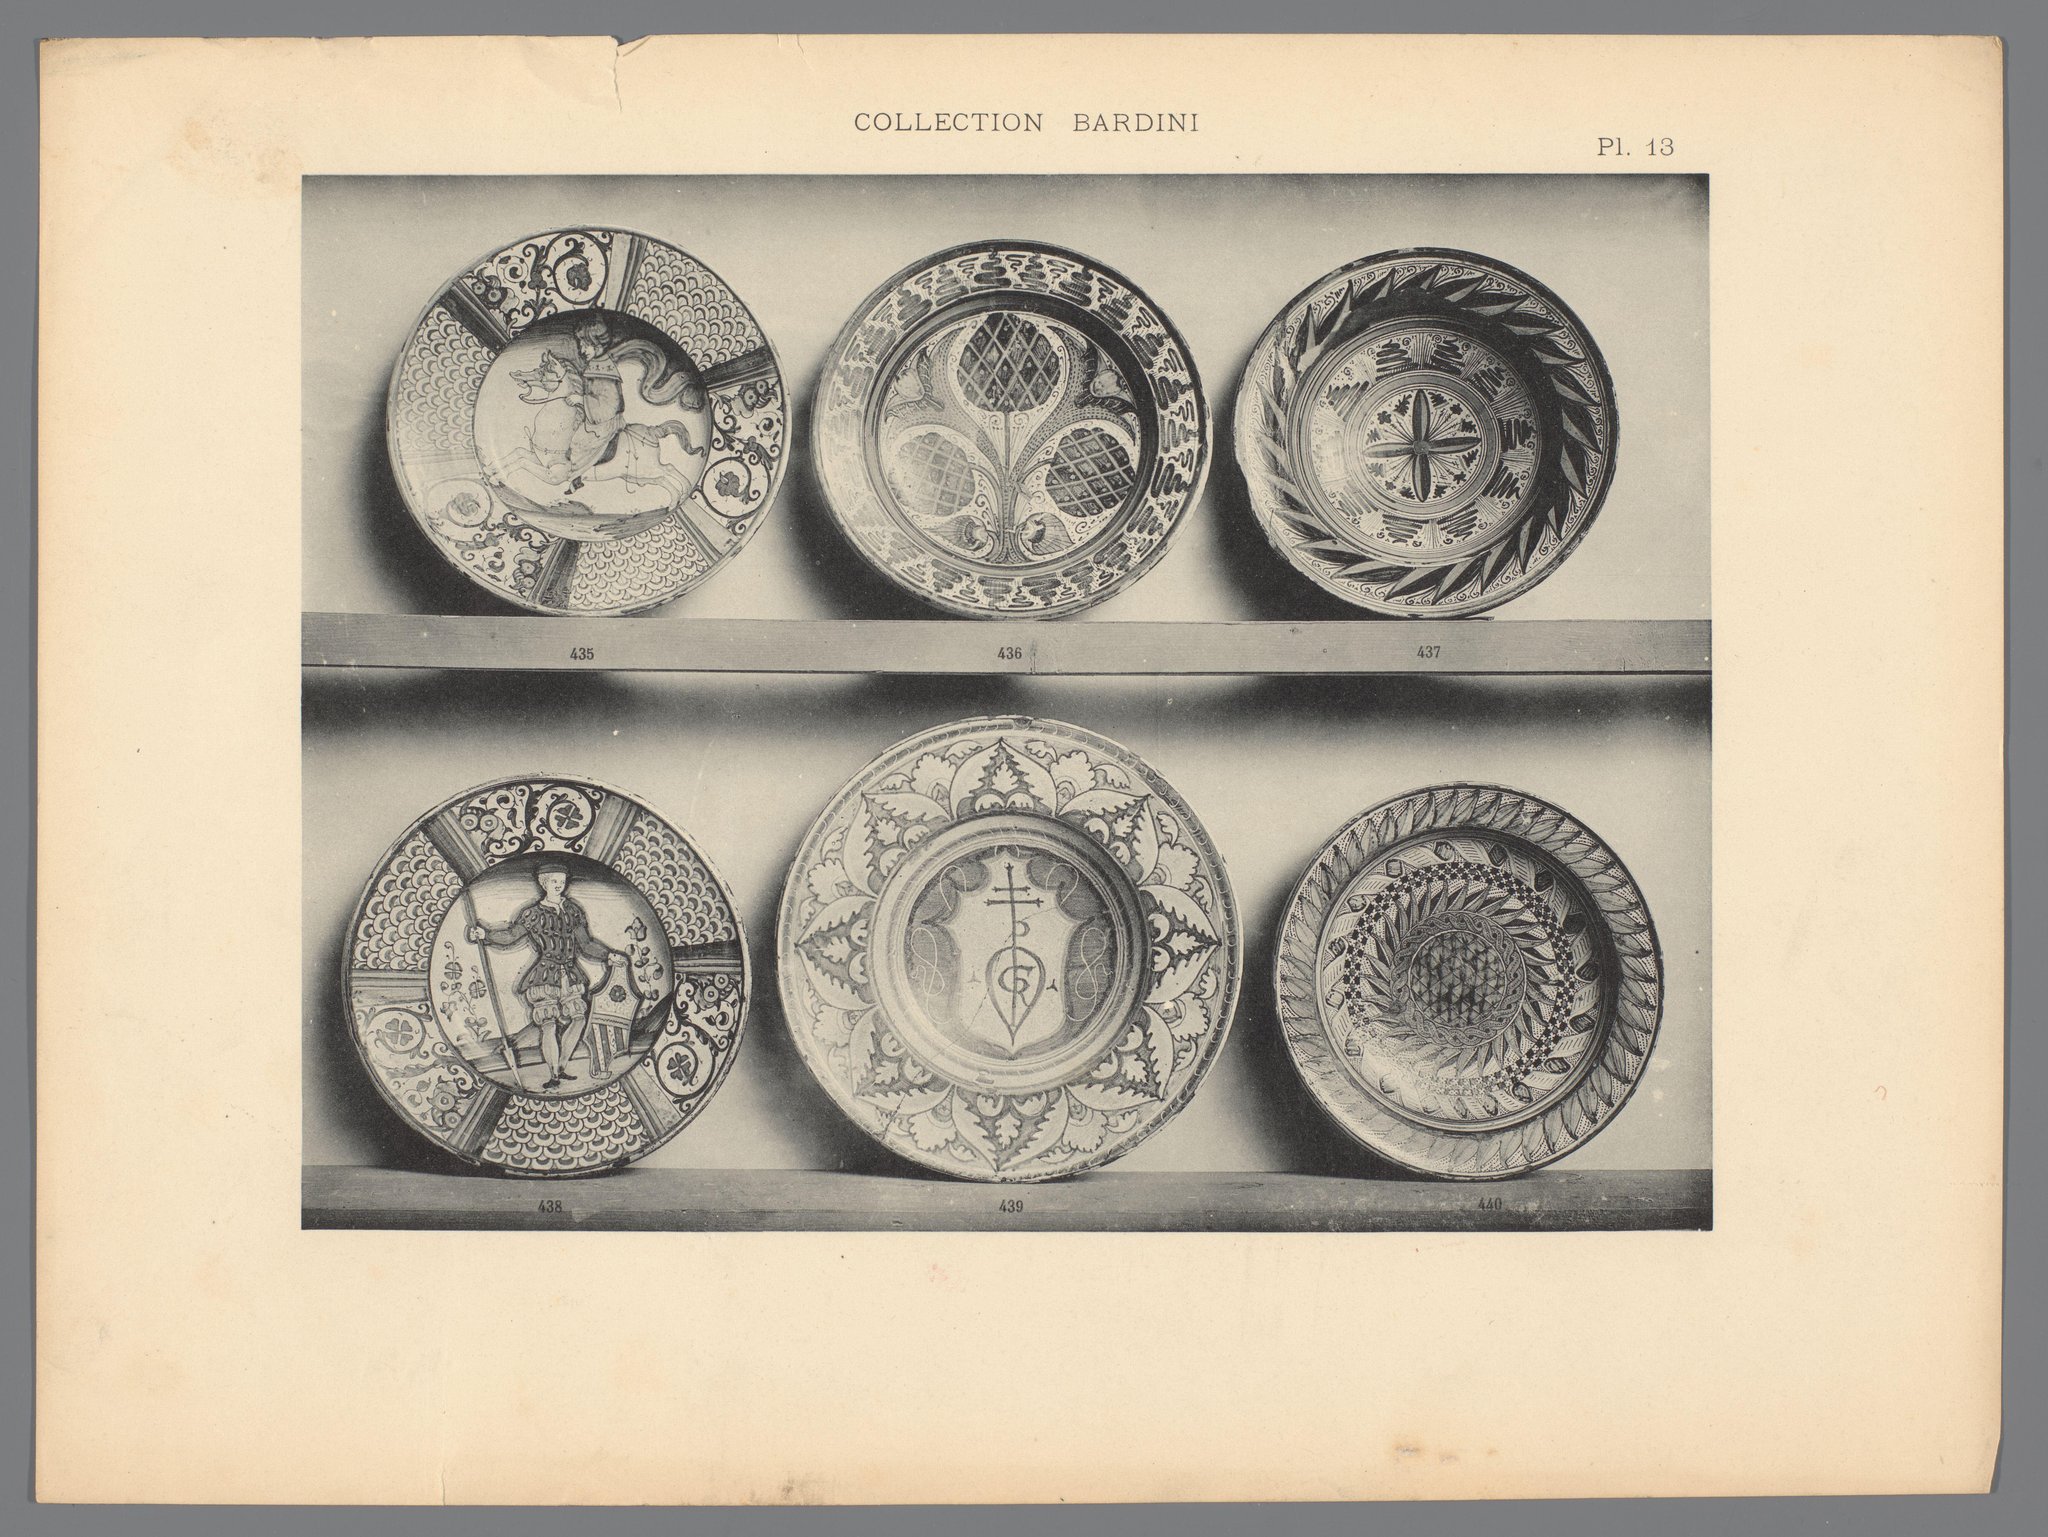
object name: photomechanical print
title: Verzameling gedecoreerde borden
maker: Anonymous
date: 1875-1930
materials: paper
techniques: photograph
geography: florence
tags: dish, plate, saucer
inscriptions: number: ‘Pl. 13’